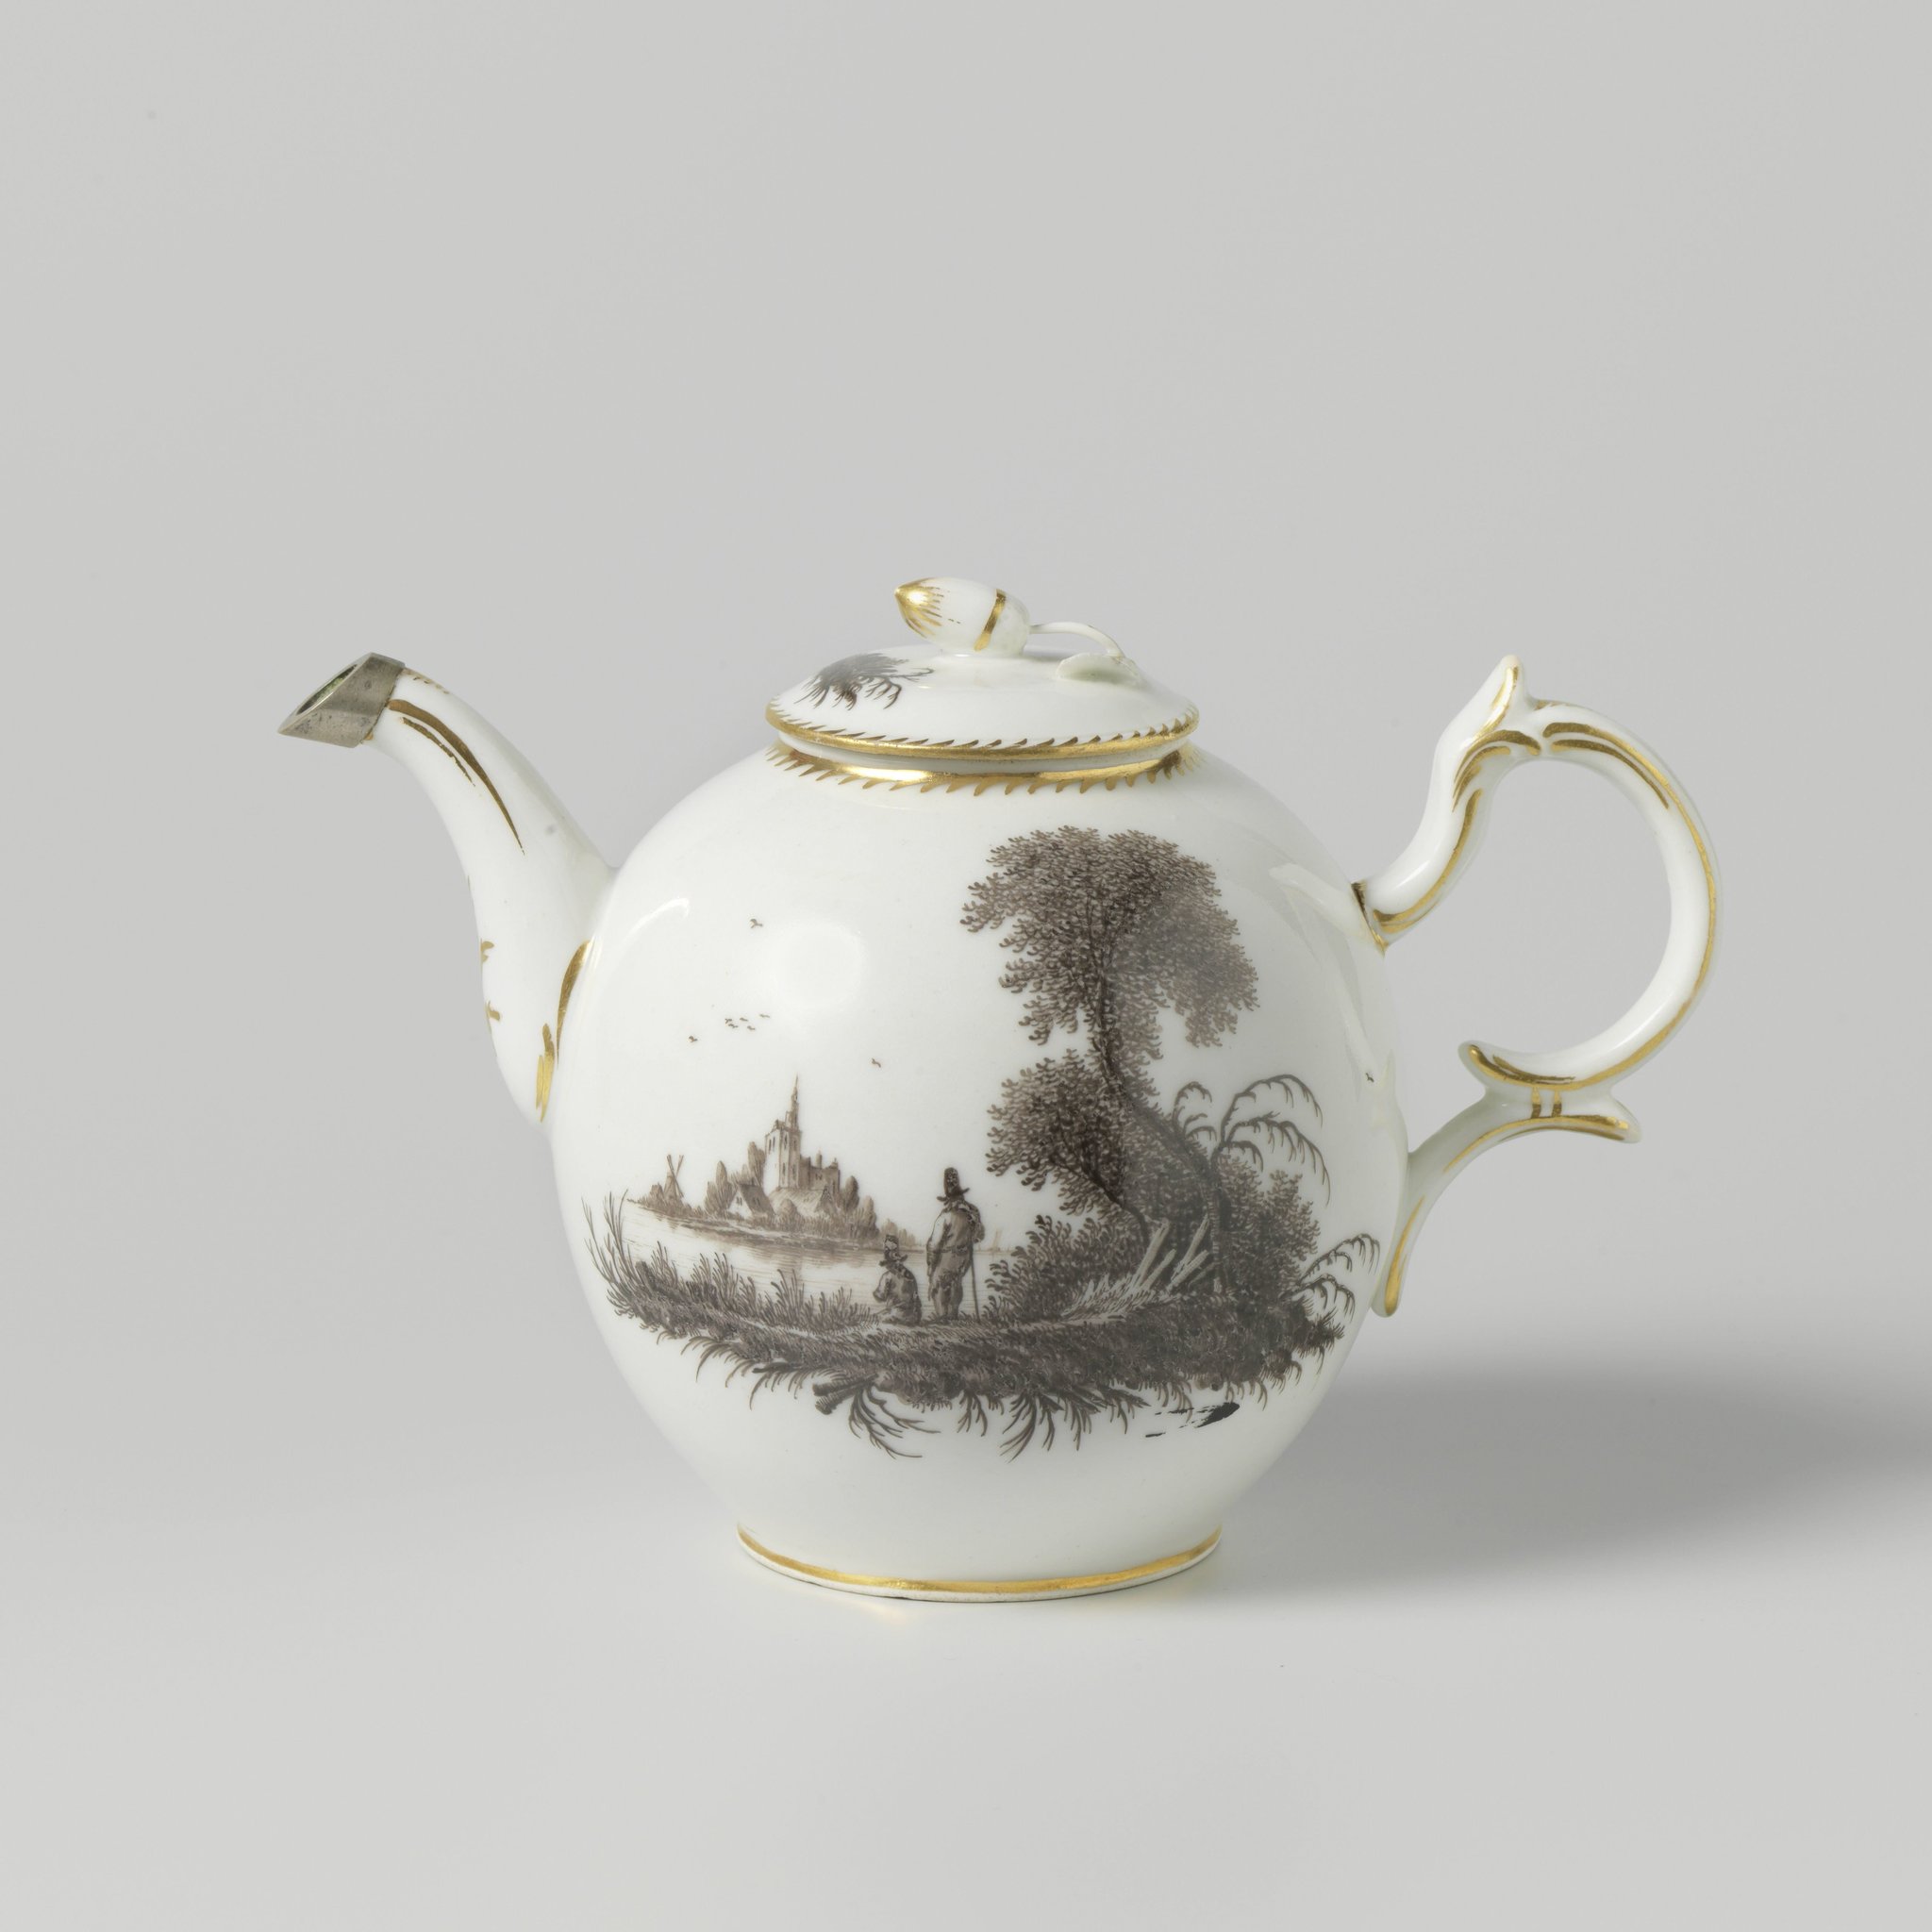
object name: teapot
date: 1774-1778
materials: porcelain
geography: loosdrecht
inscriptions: collector's mark: ‘19’, mark: ‘L // 7’, mark: ‘M [*] L’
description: Manufactuur Oud-Loosdrecht Loosdrecht, c. 1774–1778 hard-paste porcelain